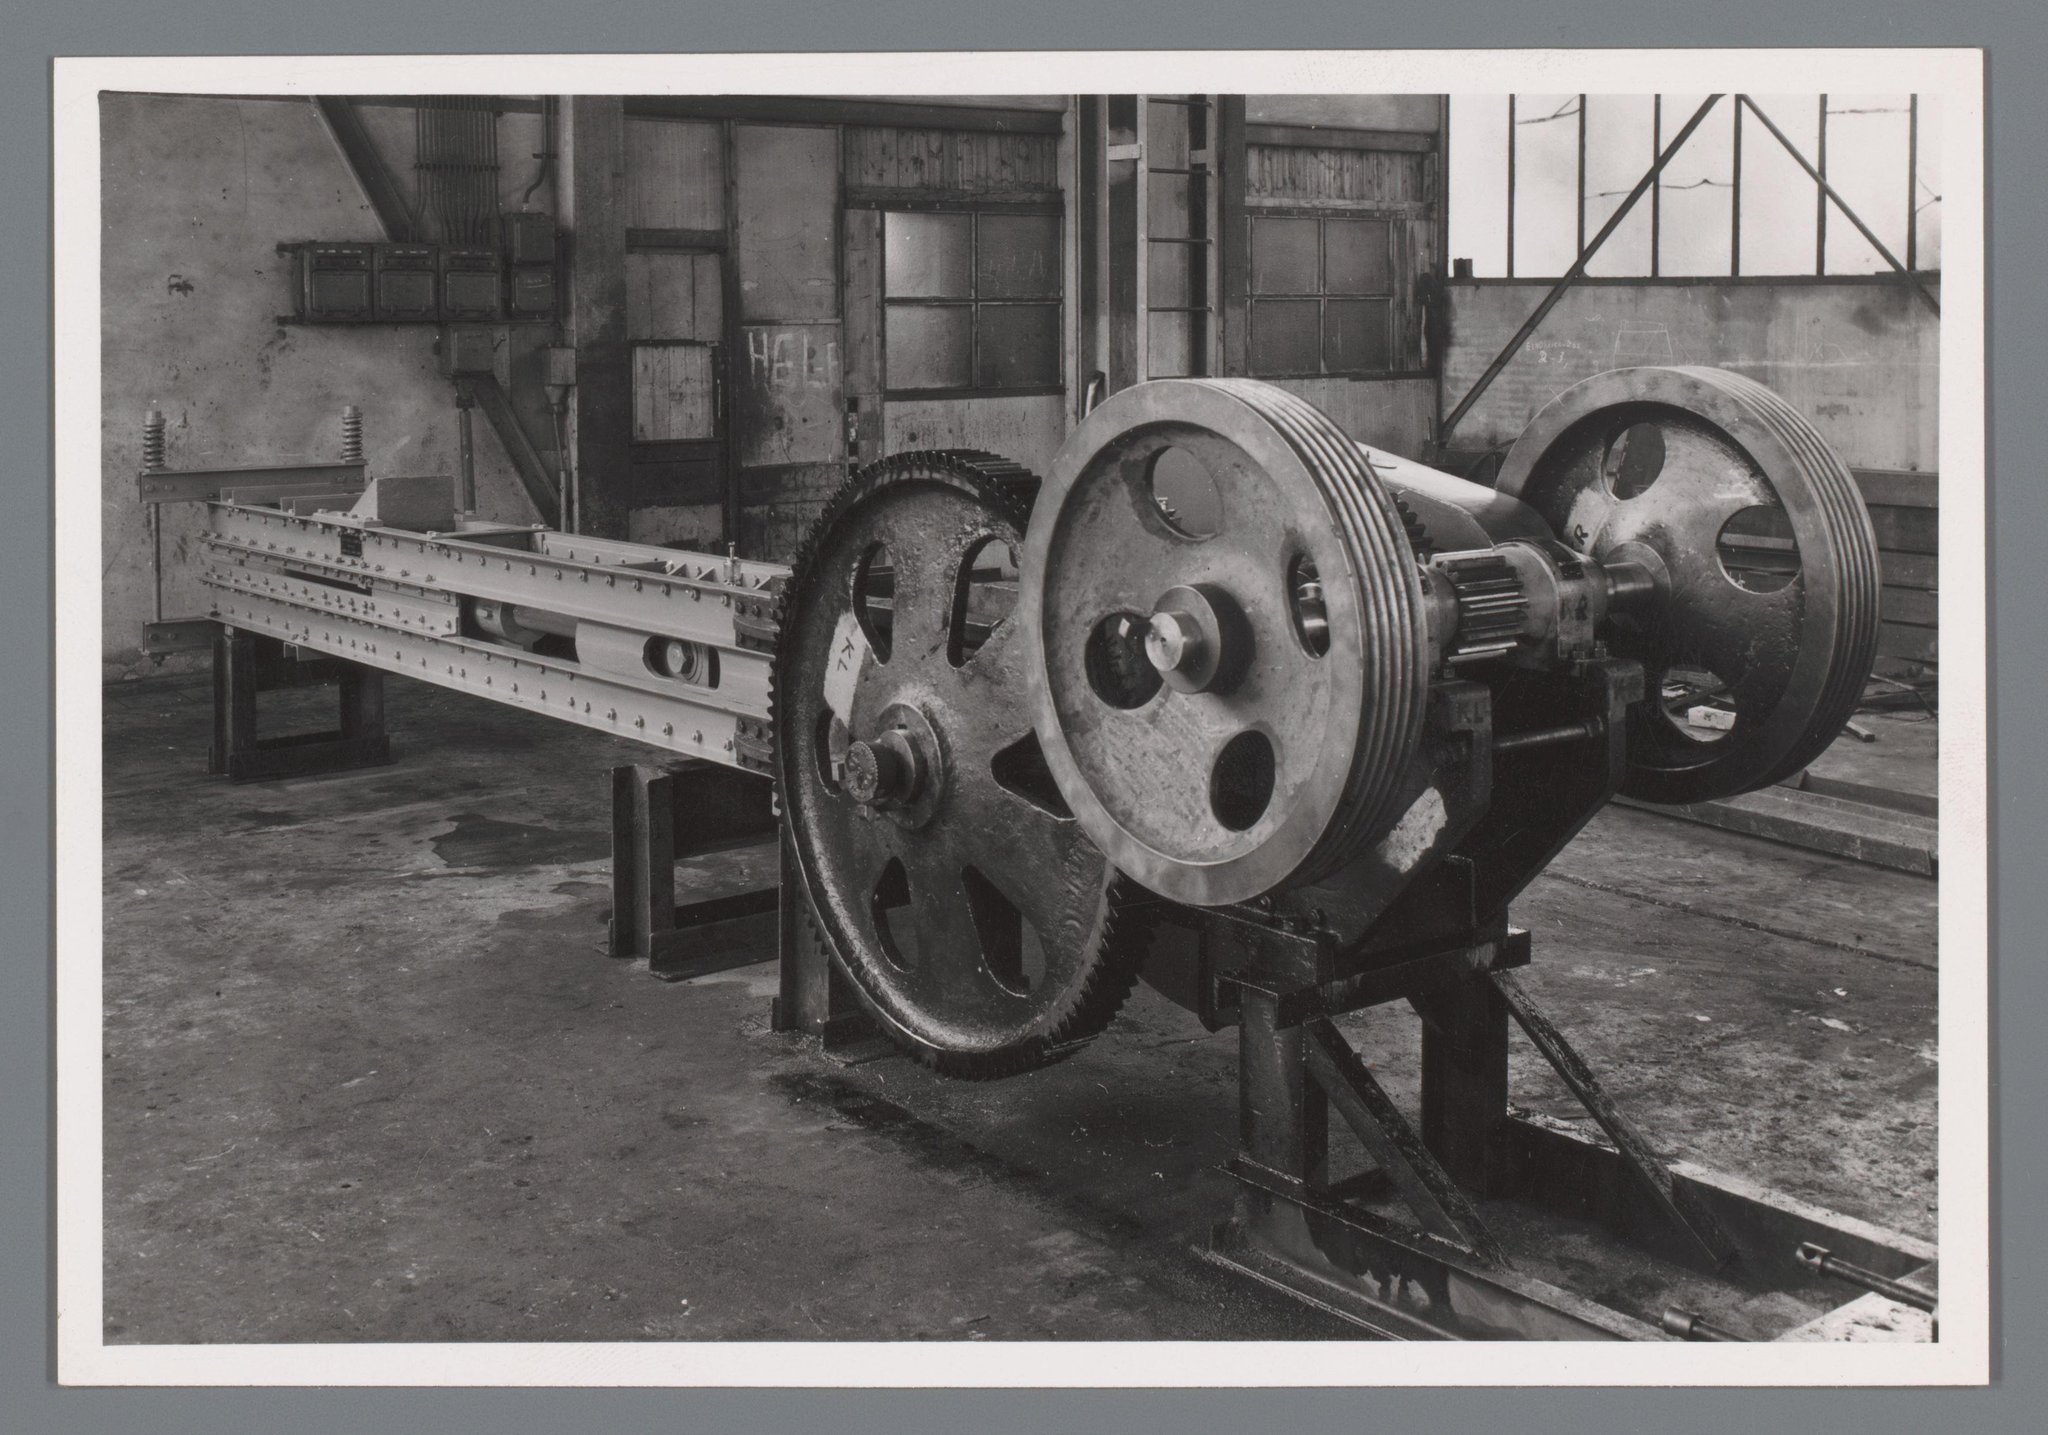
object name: photograph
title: Ampaspers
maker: Anonymous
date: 1917-1938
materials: photographic support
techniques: gelatin silver print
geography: surabaya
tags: colonial system, factory-interior, machine shop, machines; parts of machines; tools and appliances, (non-fruit) products of plants or trees: sugarcane, java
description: Ampaspers, bestemd voor een onbekende suikerfabriek. Onderdeel van de multomap met foto's van machines van de N.V. Machinefabriek Braat te Soerabaja bestemd voor de Nederlandse suikerindustrie op Java, uit de periode 1917-1938.